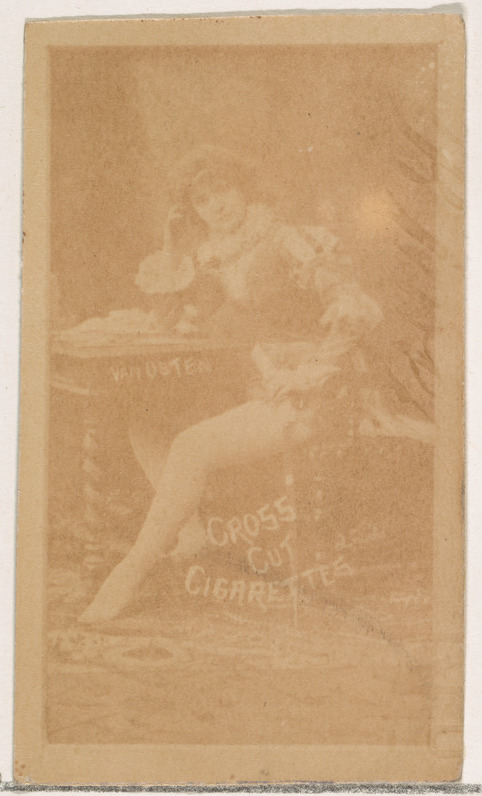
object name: print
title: Van Osten, from the Actors and Actresses series (N145-1) issued by Duke Sons & Co. to promote Cross Cut Cigarettes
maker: w. duke, sons & co.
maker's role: publisher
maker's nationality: american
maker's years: 1870-1920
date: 1880-1889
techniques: albumen silver print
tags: portraits,women,actresses